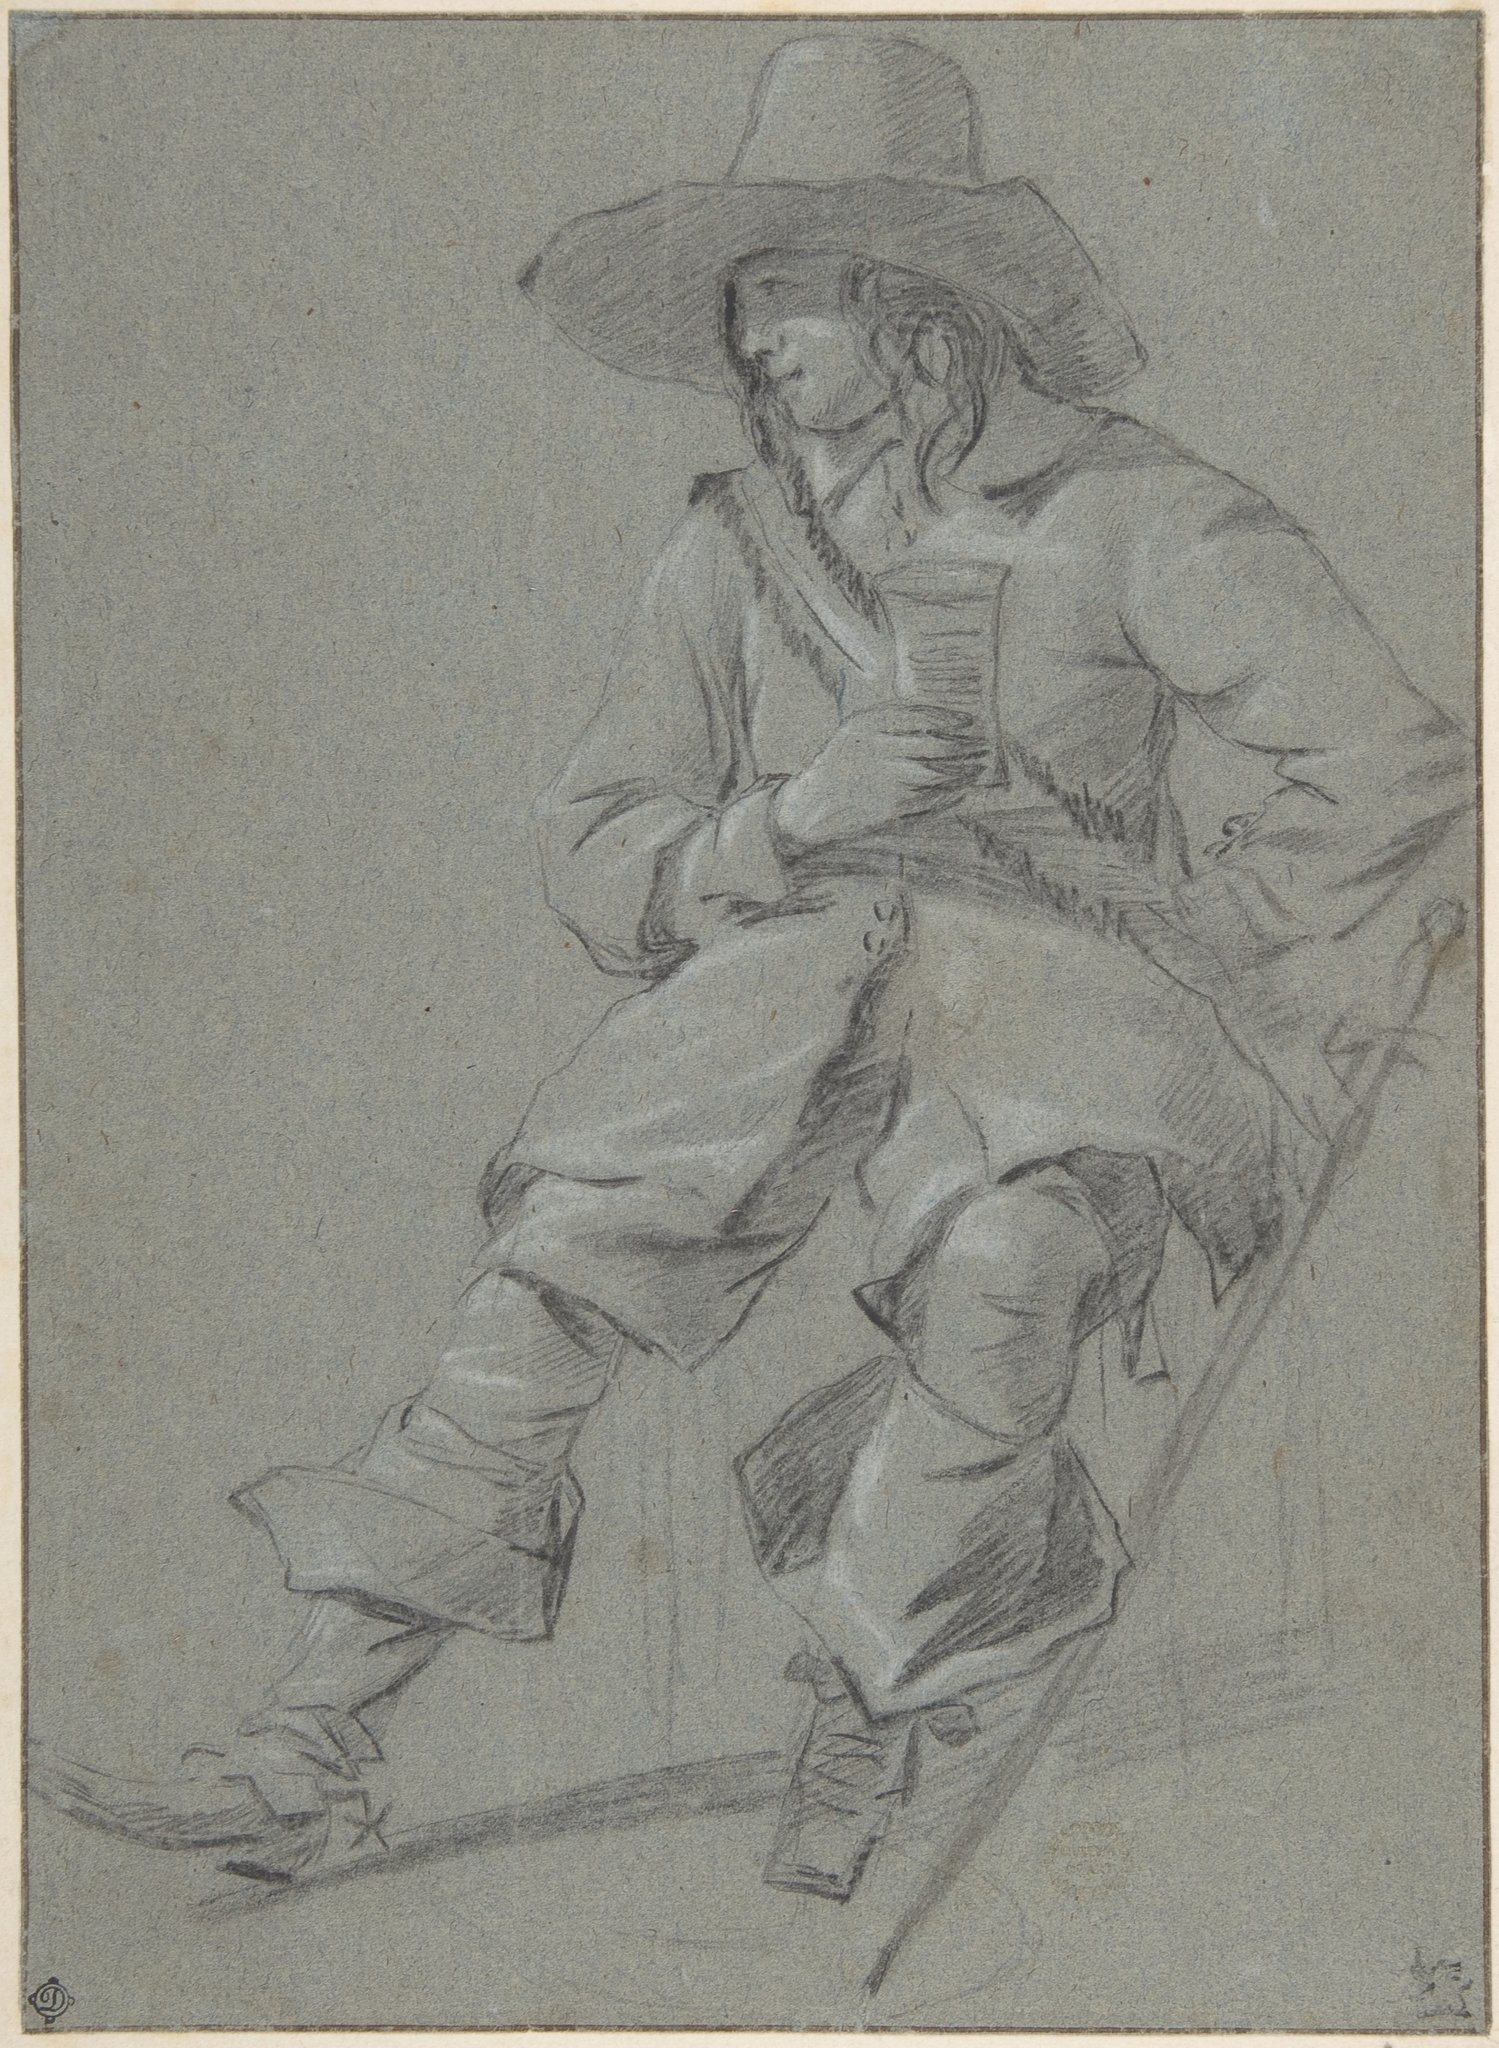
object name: drawing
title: Seated Cavalier with Glass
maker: gabriël metsu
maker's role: artist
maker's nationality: dutch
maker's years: 1629-1667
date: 1634-1666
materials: chalk, paper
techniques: heightening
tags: hats,men,drinking glasses